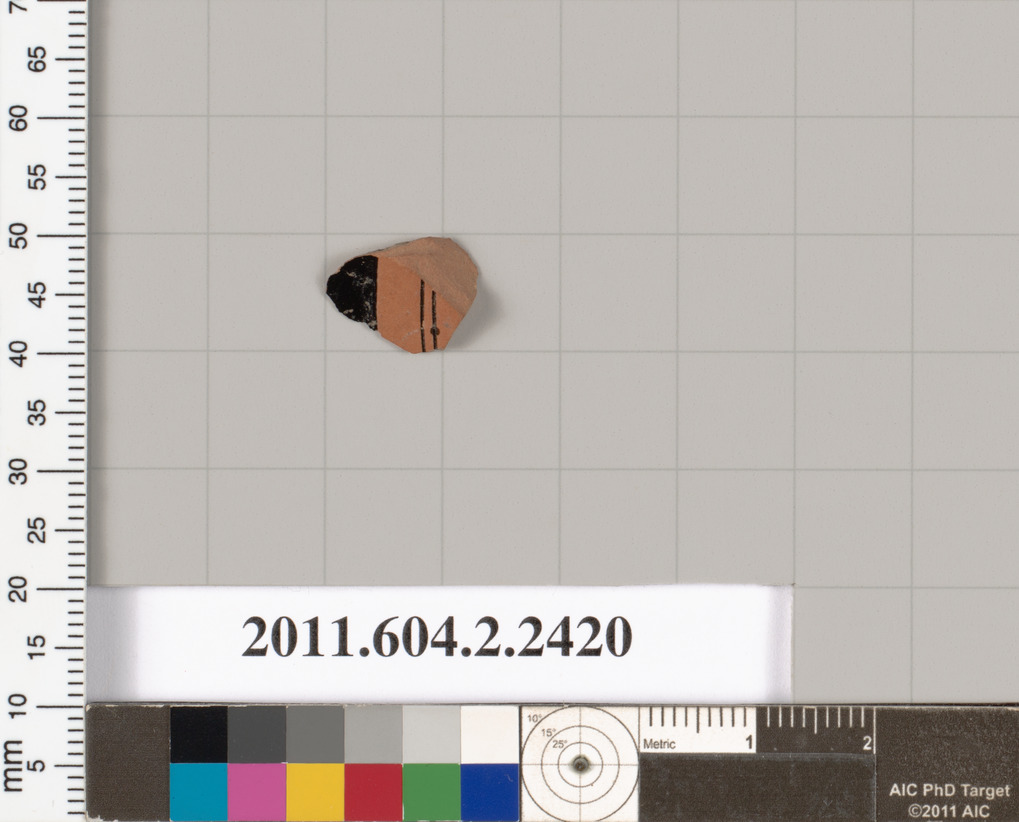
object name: undetermined shape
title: Terracotta fragment of an undetermined shape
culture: greek, attic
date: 490-470 BCE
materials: terracotta